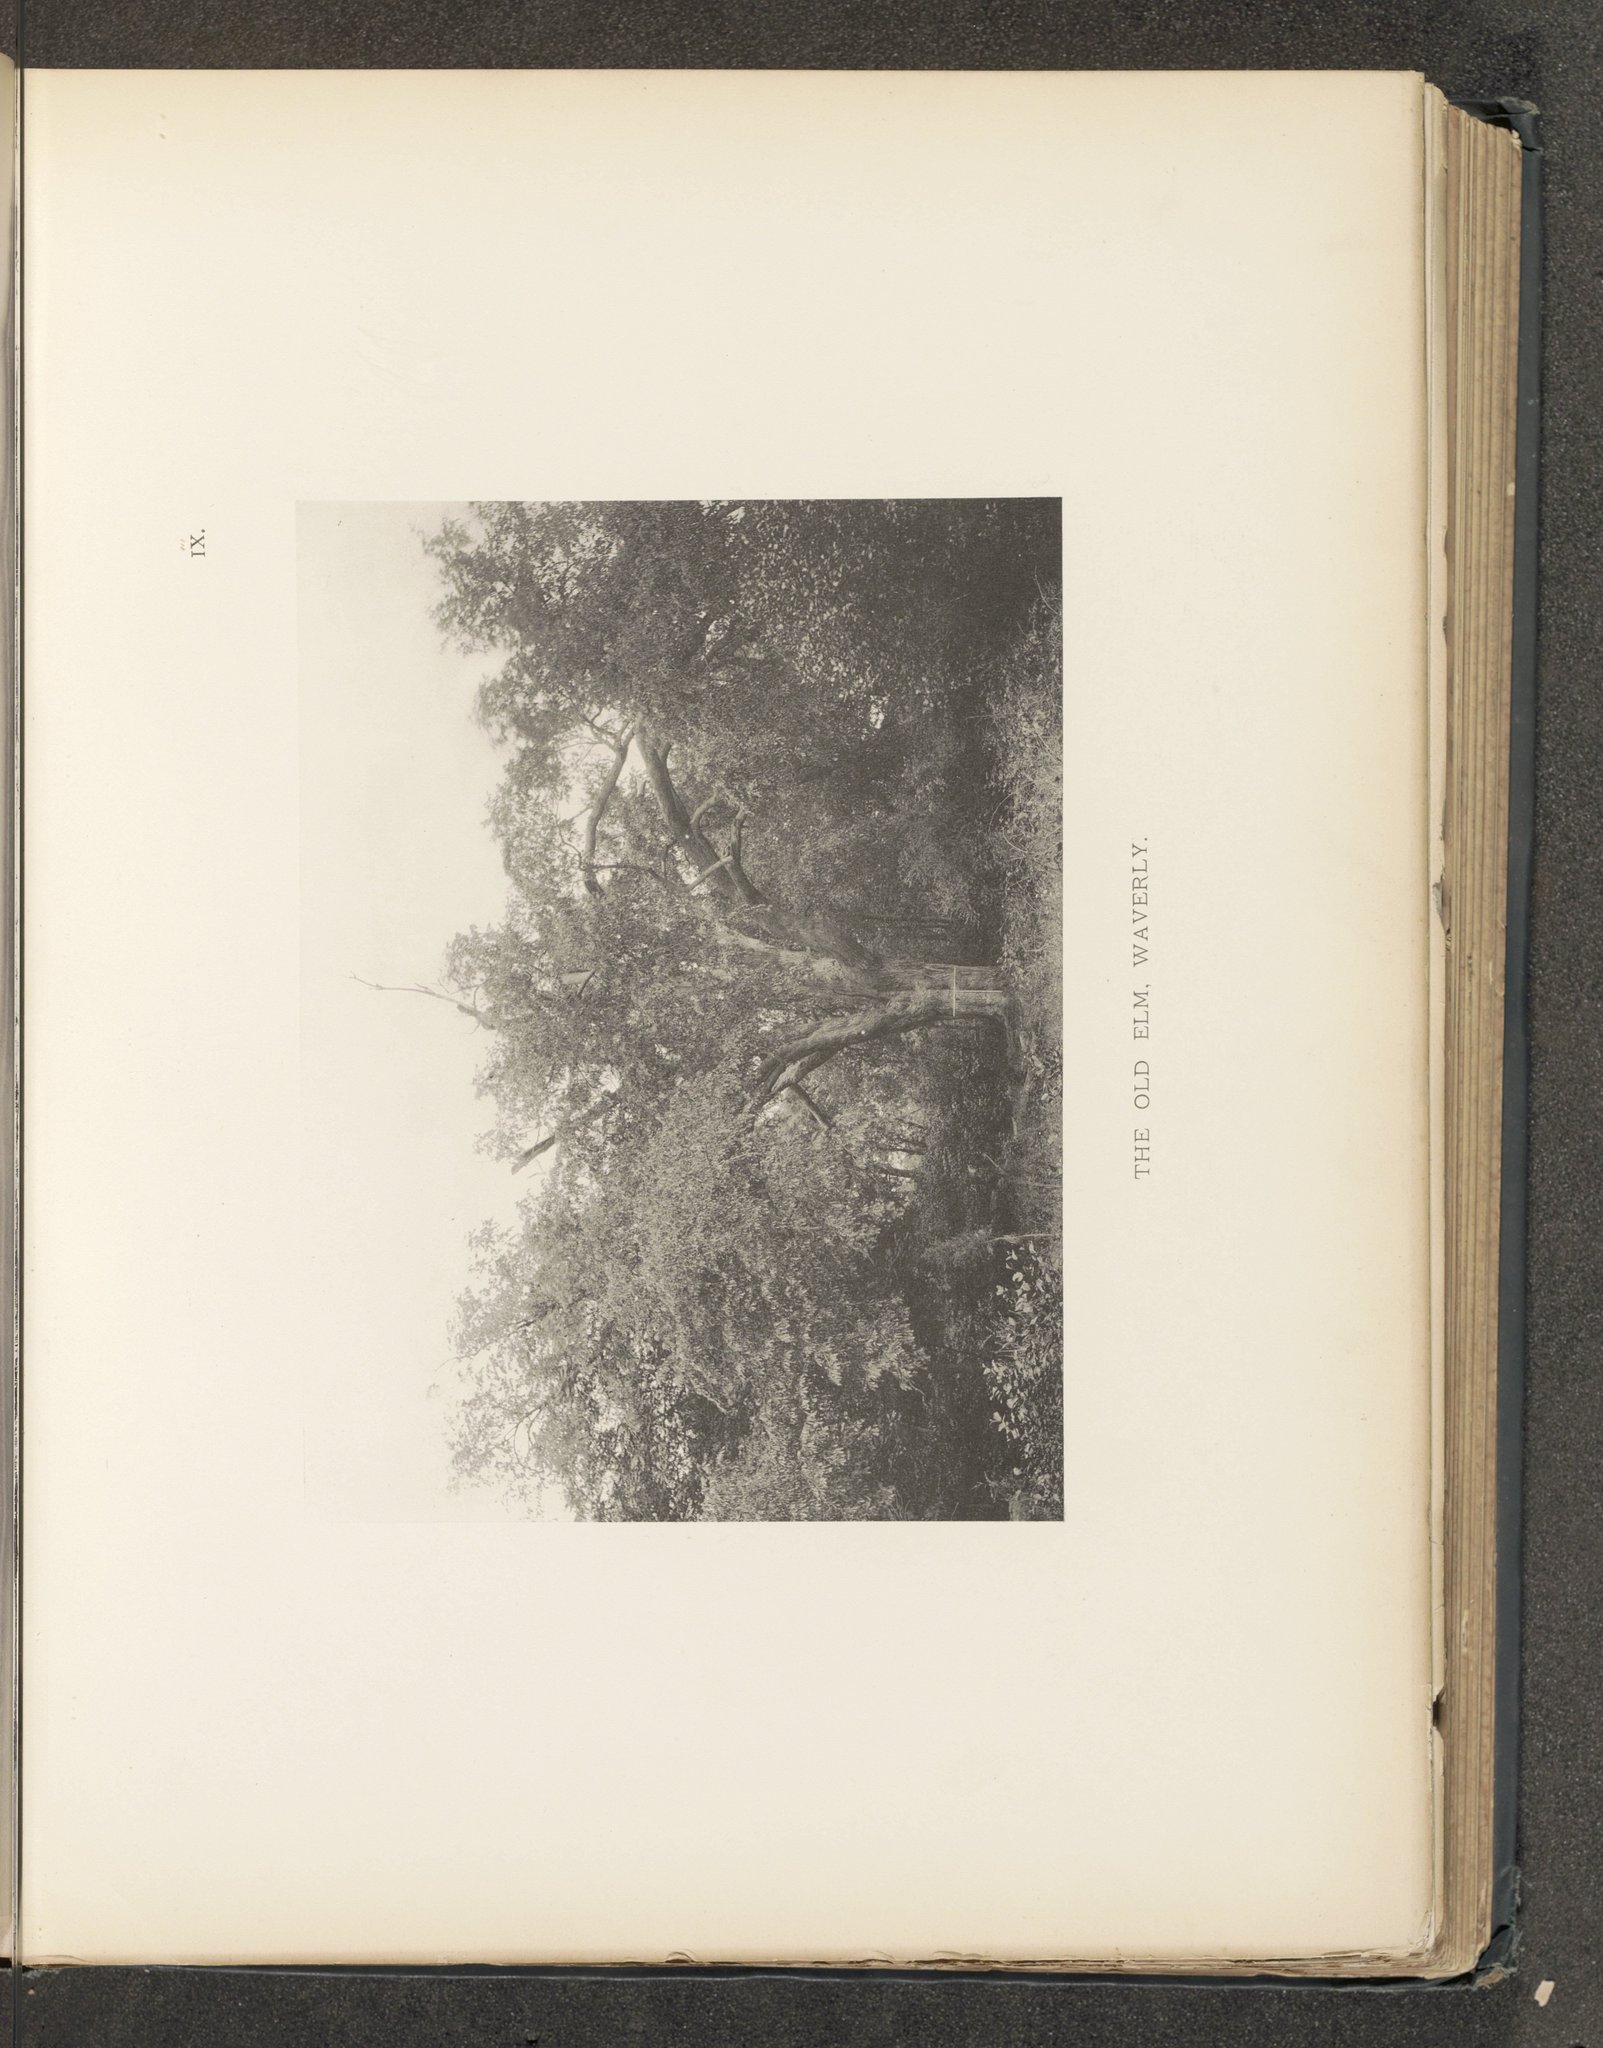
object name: page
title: The old elm, Waverly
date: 1880-1890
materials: paper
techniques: photograph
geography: massachusetts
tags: trees: elm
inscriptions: number: ‘IX.’